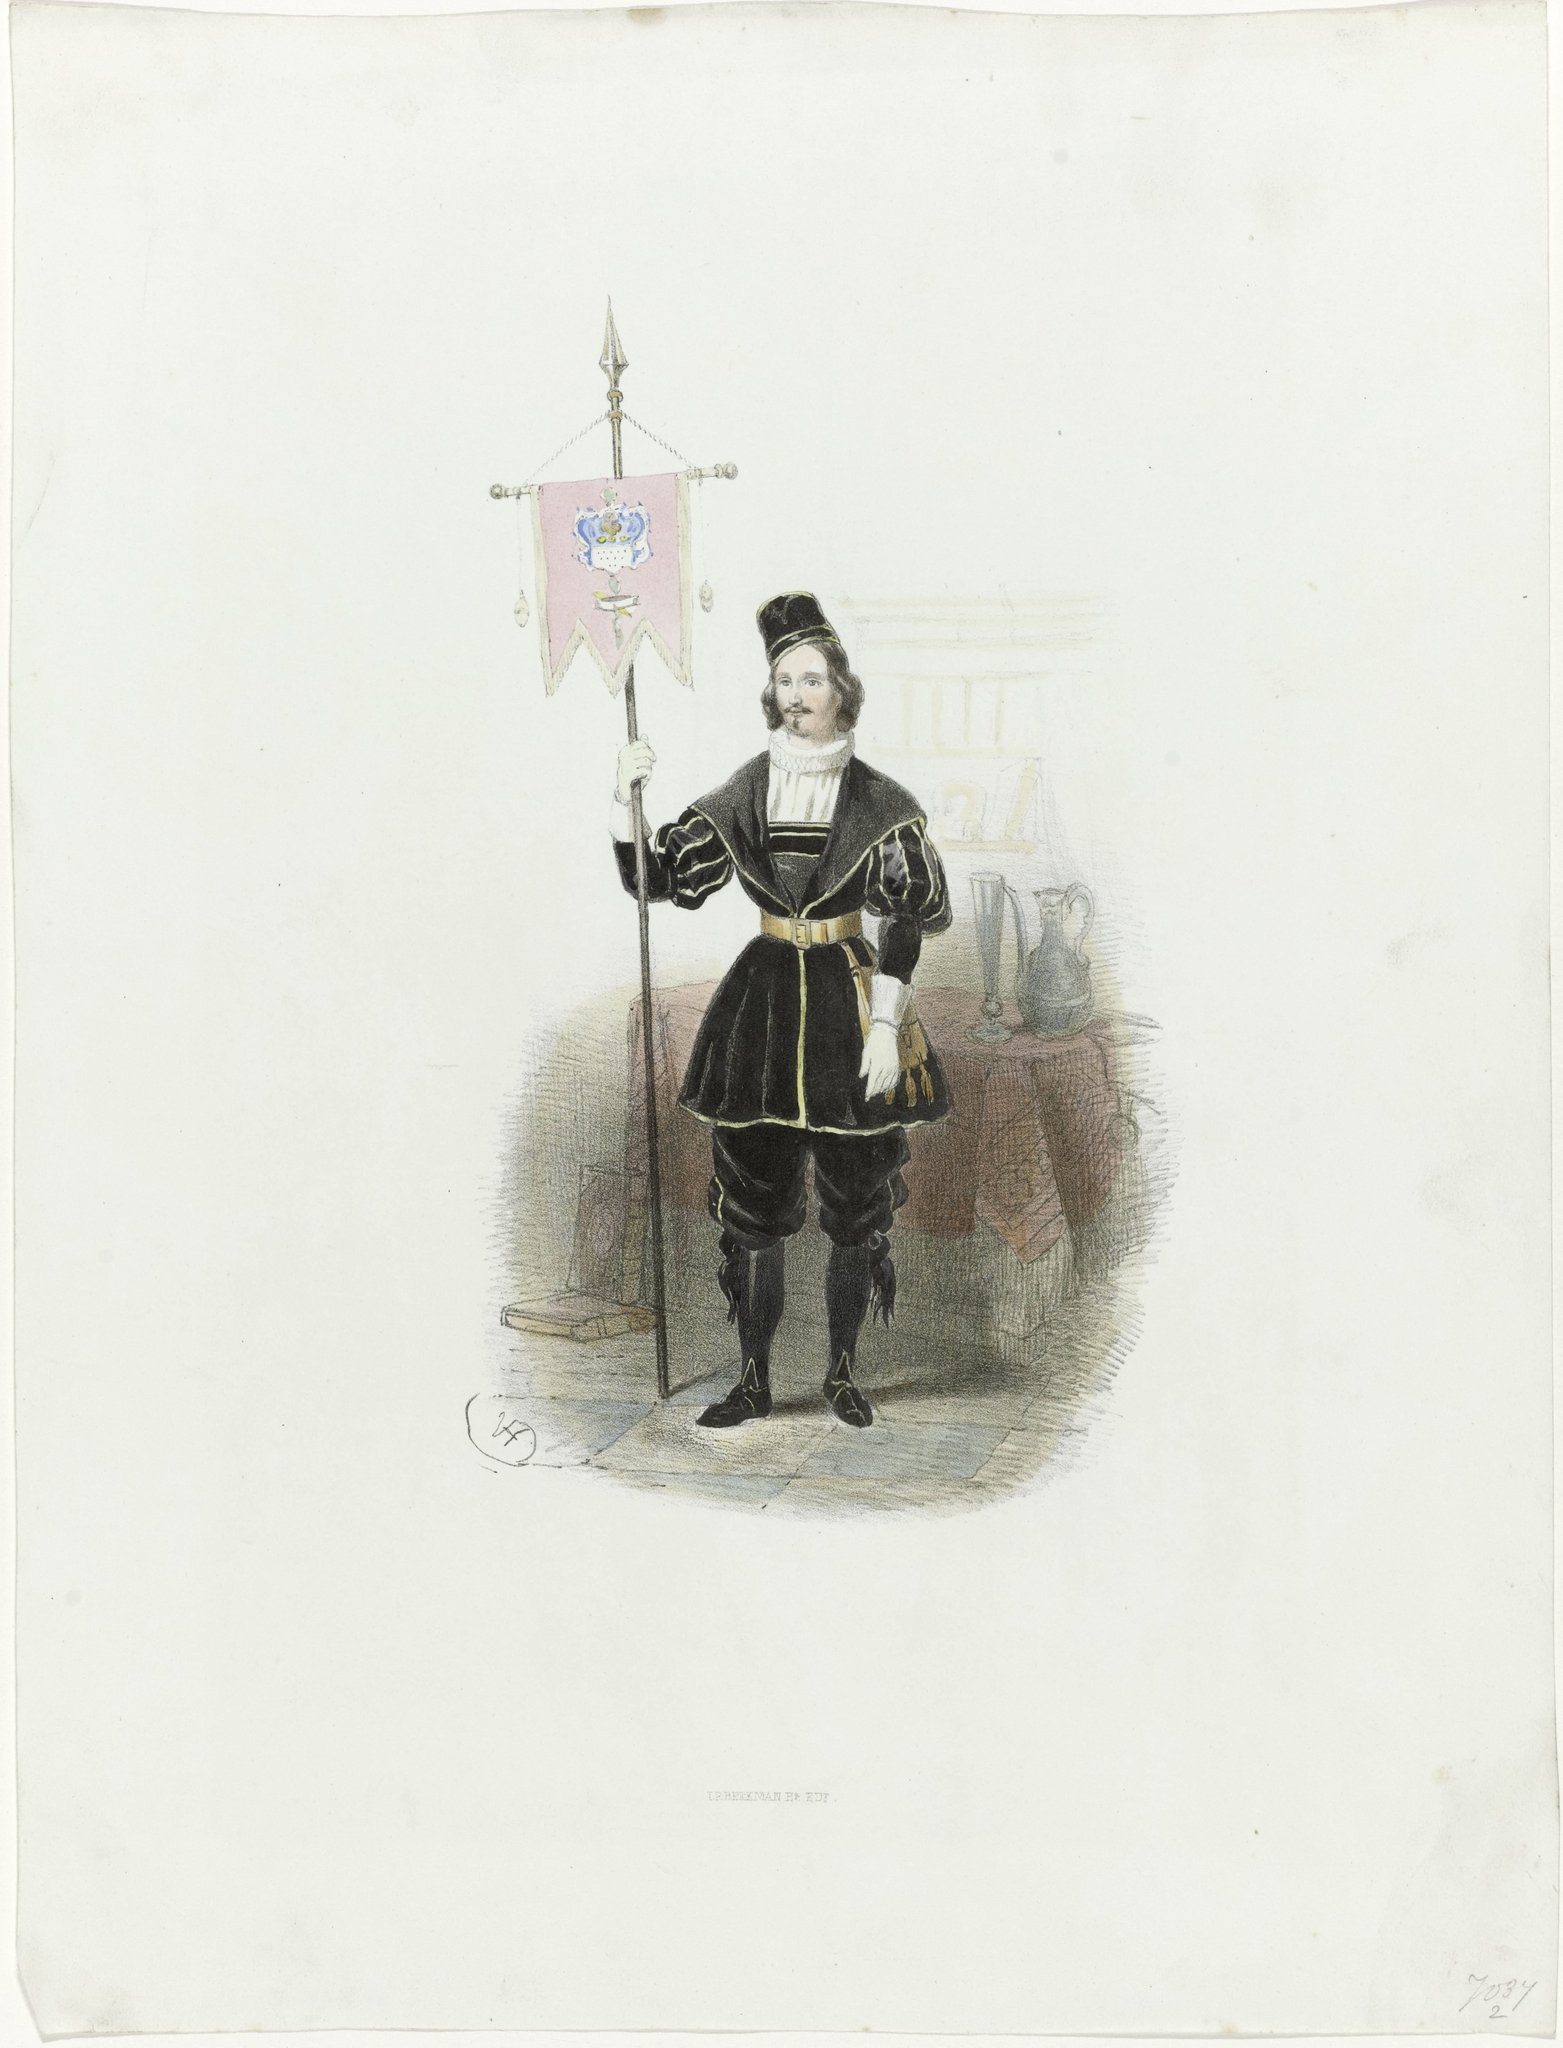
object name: print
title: Album van het Gekostumeerd Bal, 17 en 19 February 1841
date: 1841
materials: paper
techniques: hand coloring, lithograph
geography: the hague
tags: anna paulowna romanowa, the hague, william ii of the netherlands, historical costume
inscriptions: collector's mark: Lugt 2228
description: Vrouw in historisch kostuum van een vaandeldrager. Onderdeel van het album bestaande uit een omslag en zes platen van kostuums gedragen op het gekostumeerde bal gehouden te Den Haag op 17 en 19 februari 1841 ter gelegenheid van het 25-jarig huwelijk van koning Willem II en Anna Paulowna.